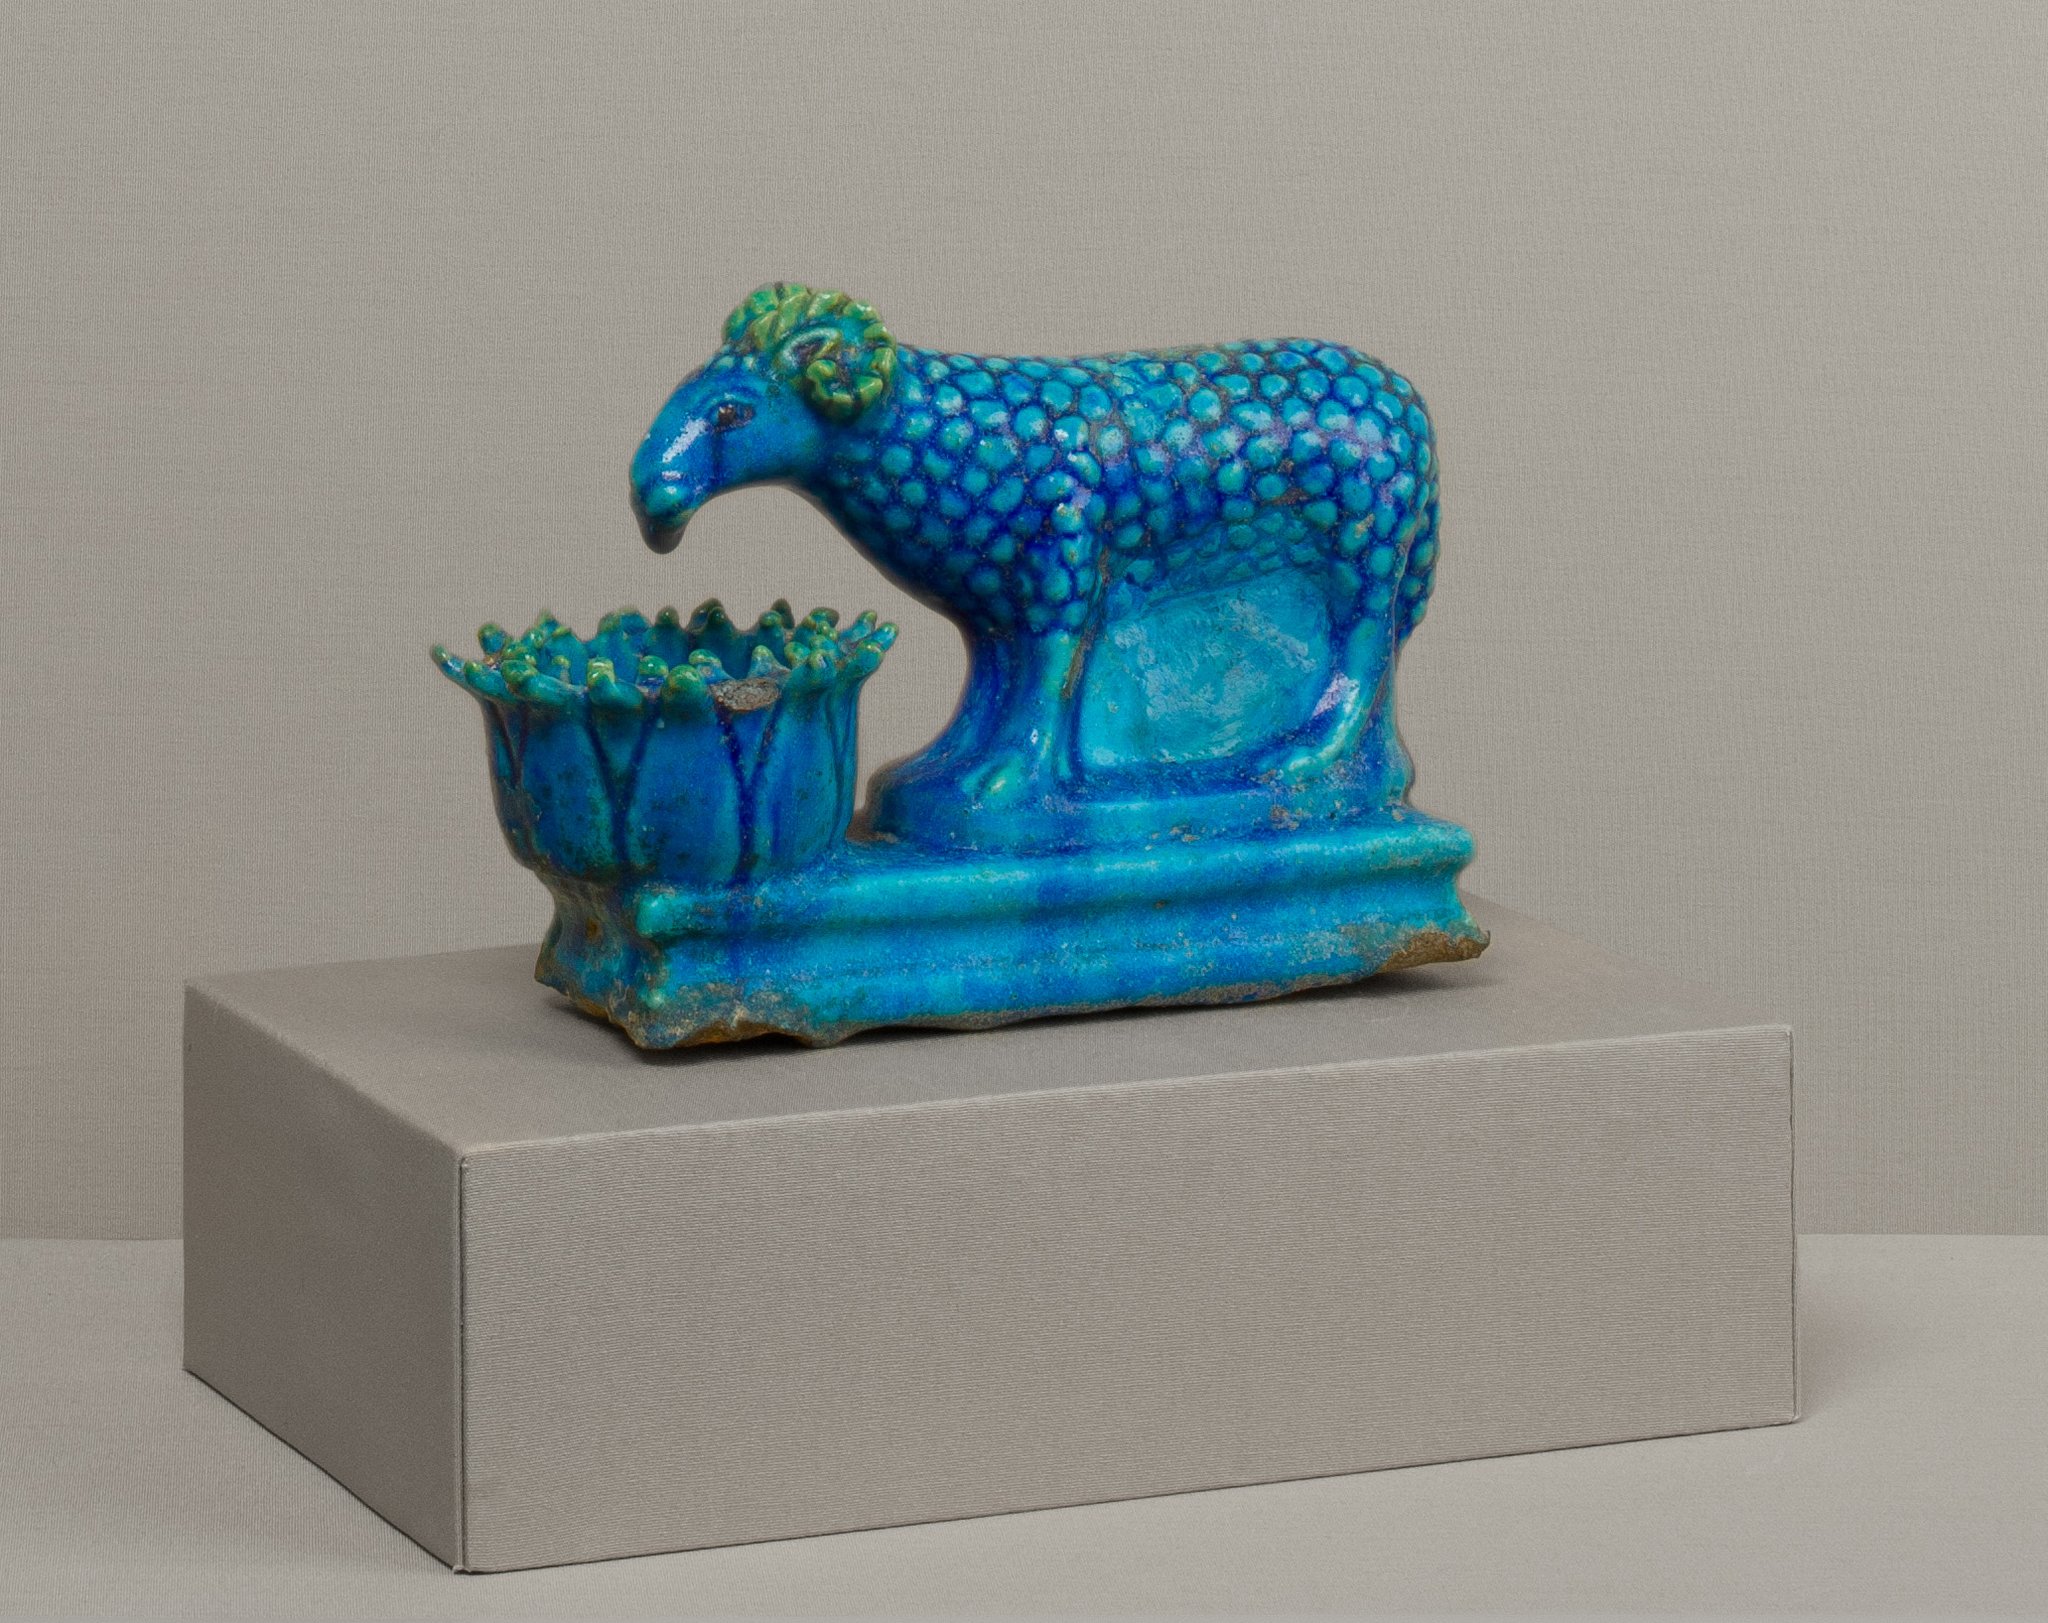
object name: vessel, ram with lotus bowl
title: Ram with lotus-shaped manger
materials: faience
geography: fayum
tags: rams,lotuses